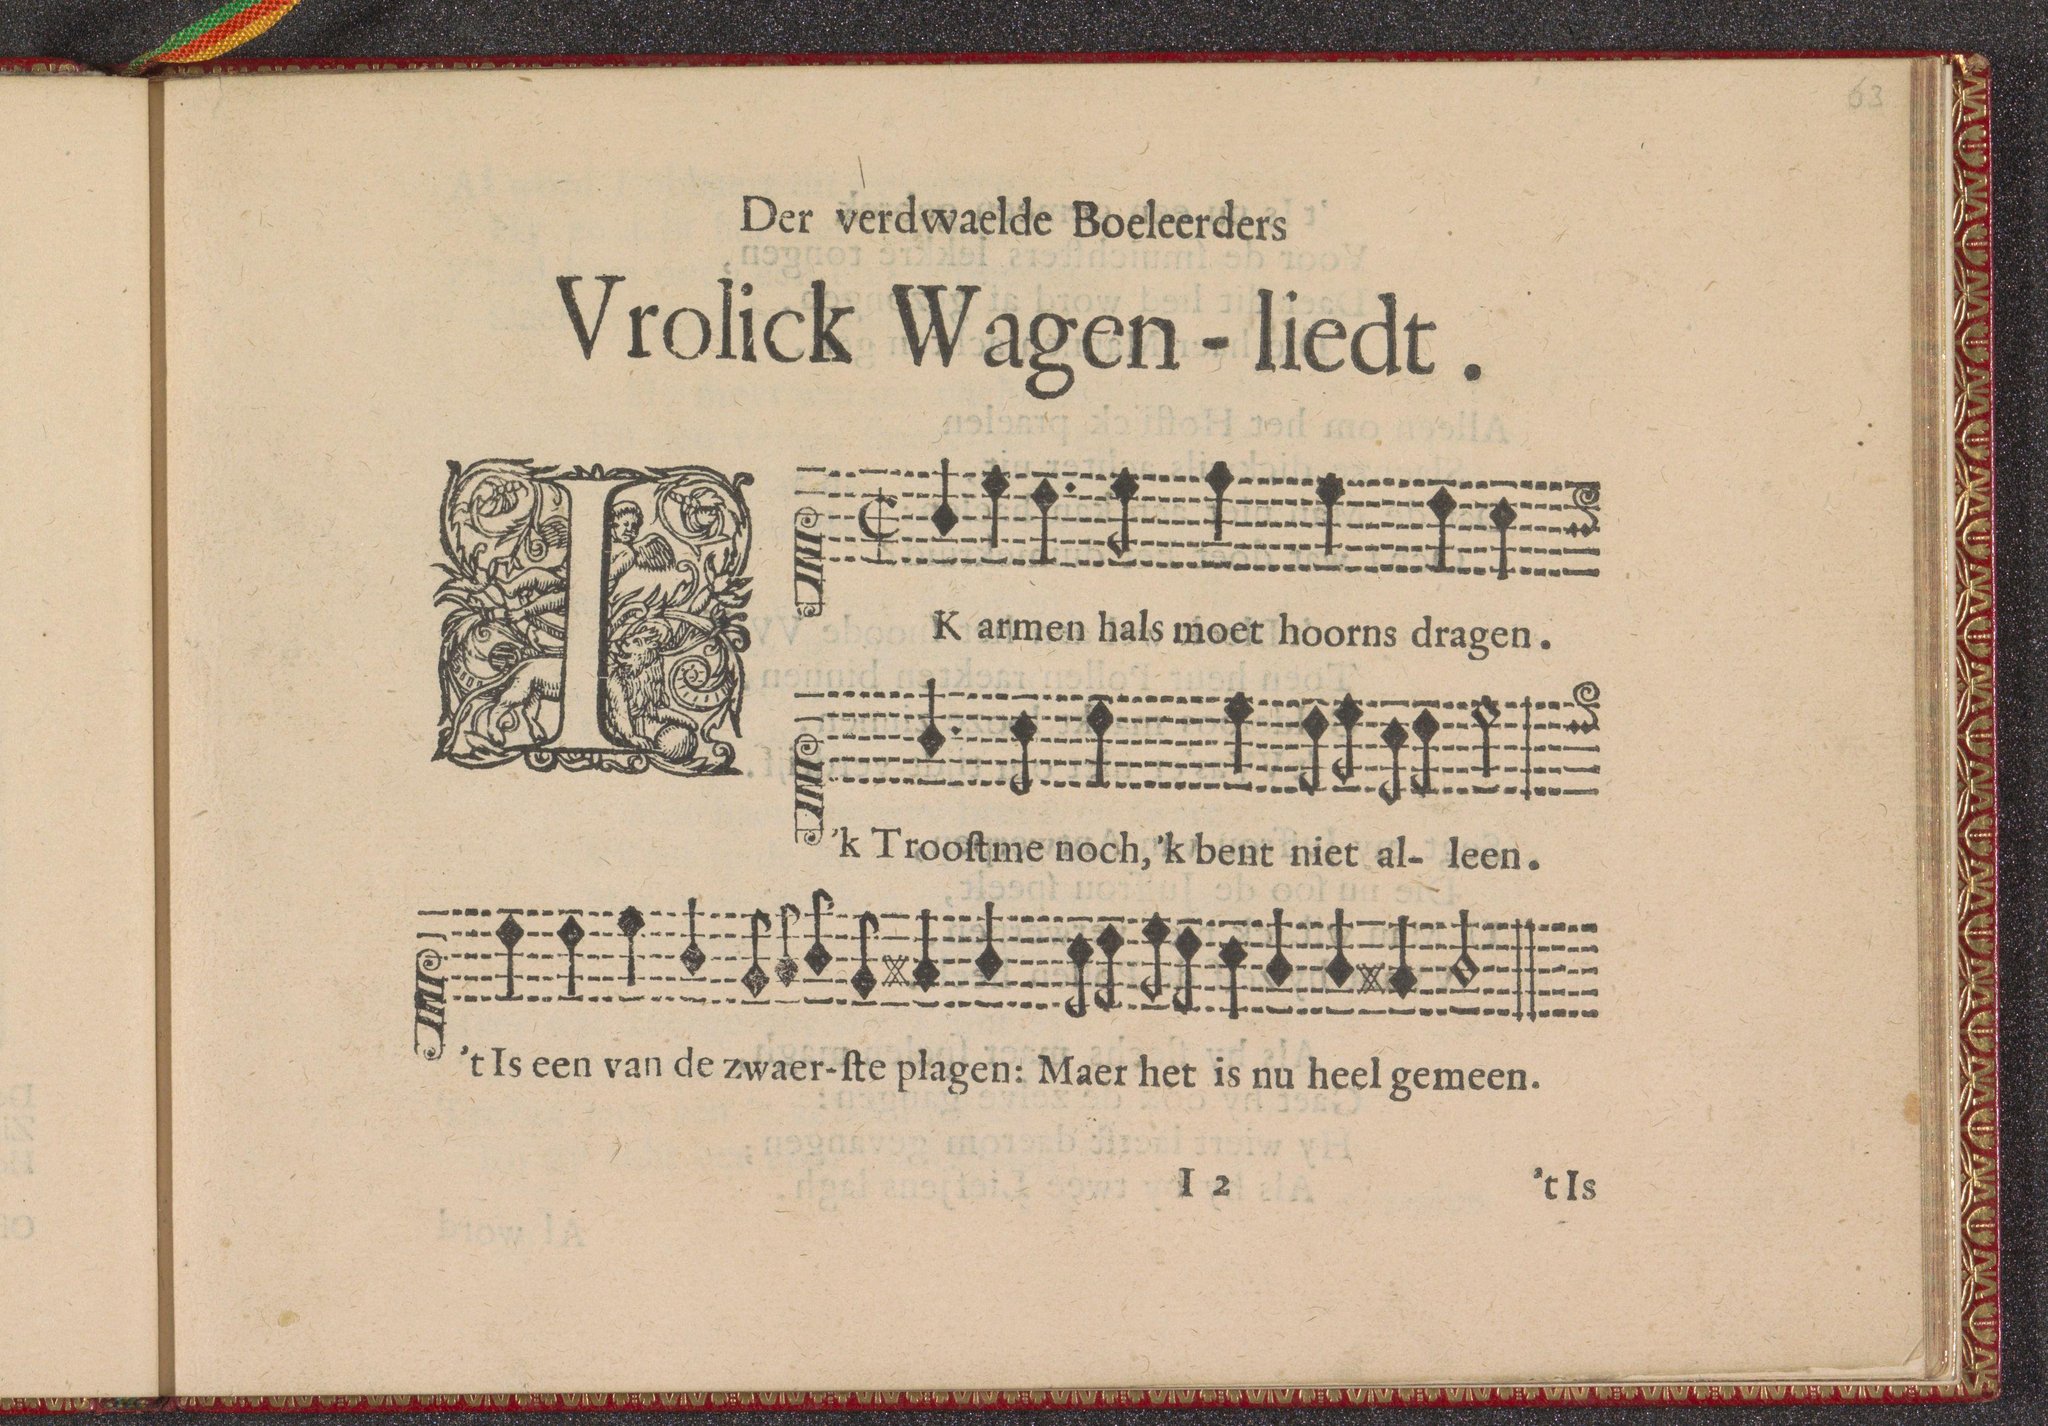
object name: album leaf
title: Wagenlied, pagina 1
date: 1641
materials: paper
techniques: letterpress printing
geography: amsterdam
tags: initial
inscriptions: date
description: Wagenlied op zeven pagina's: pagina 1. Vier versregels in het Nederlands onder drie notenbalken. De tekst vangt aan met een gedecoreerde initiaal I. Het blad maakt deel uit van een album.